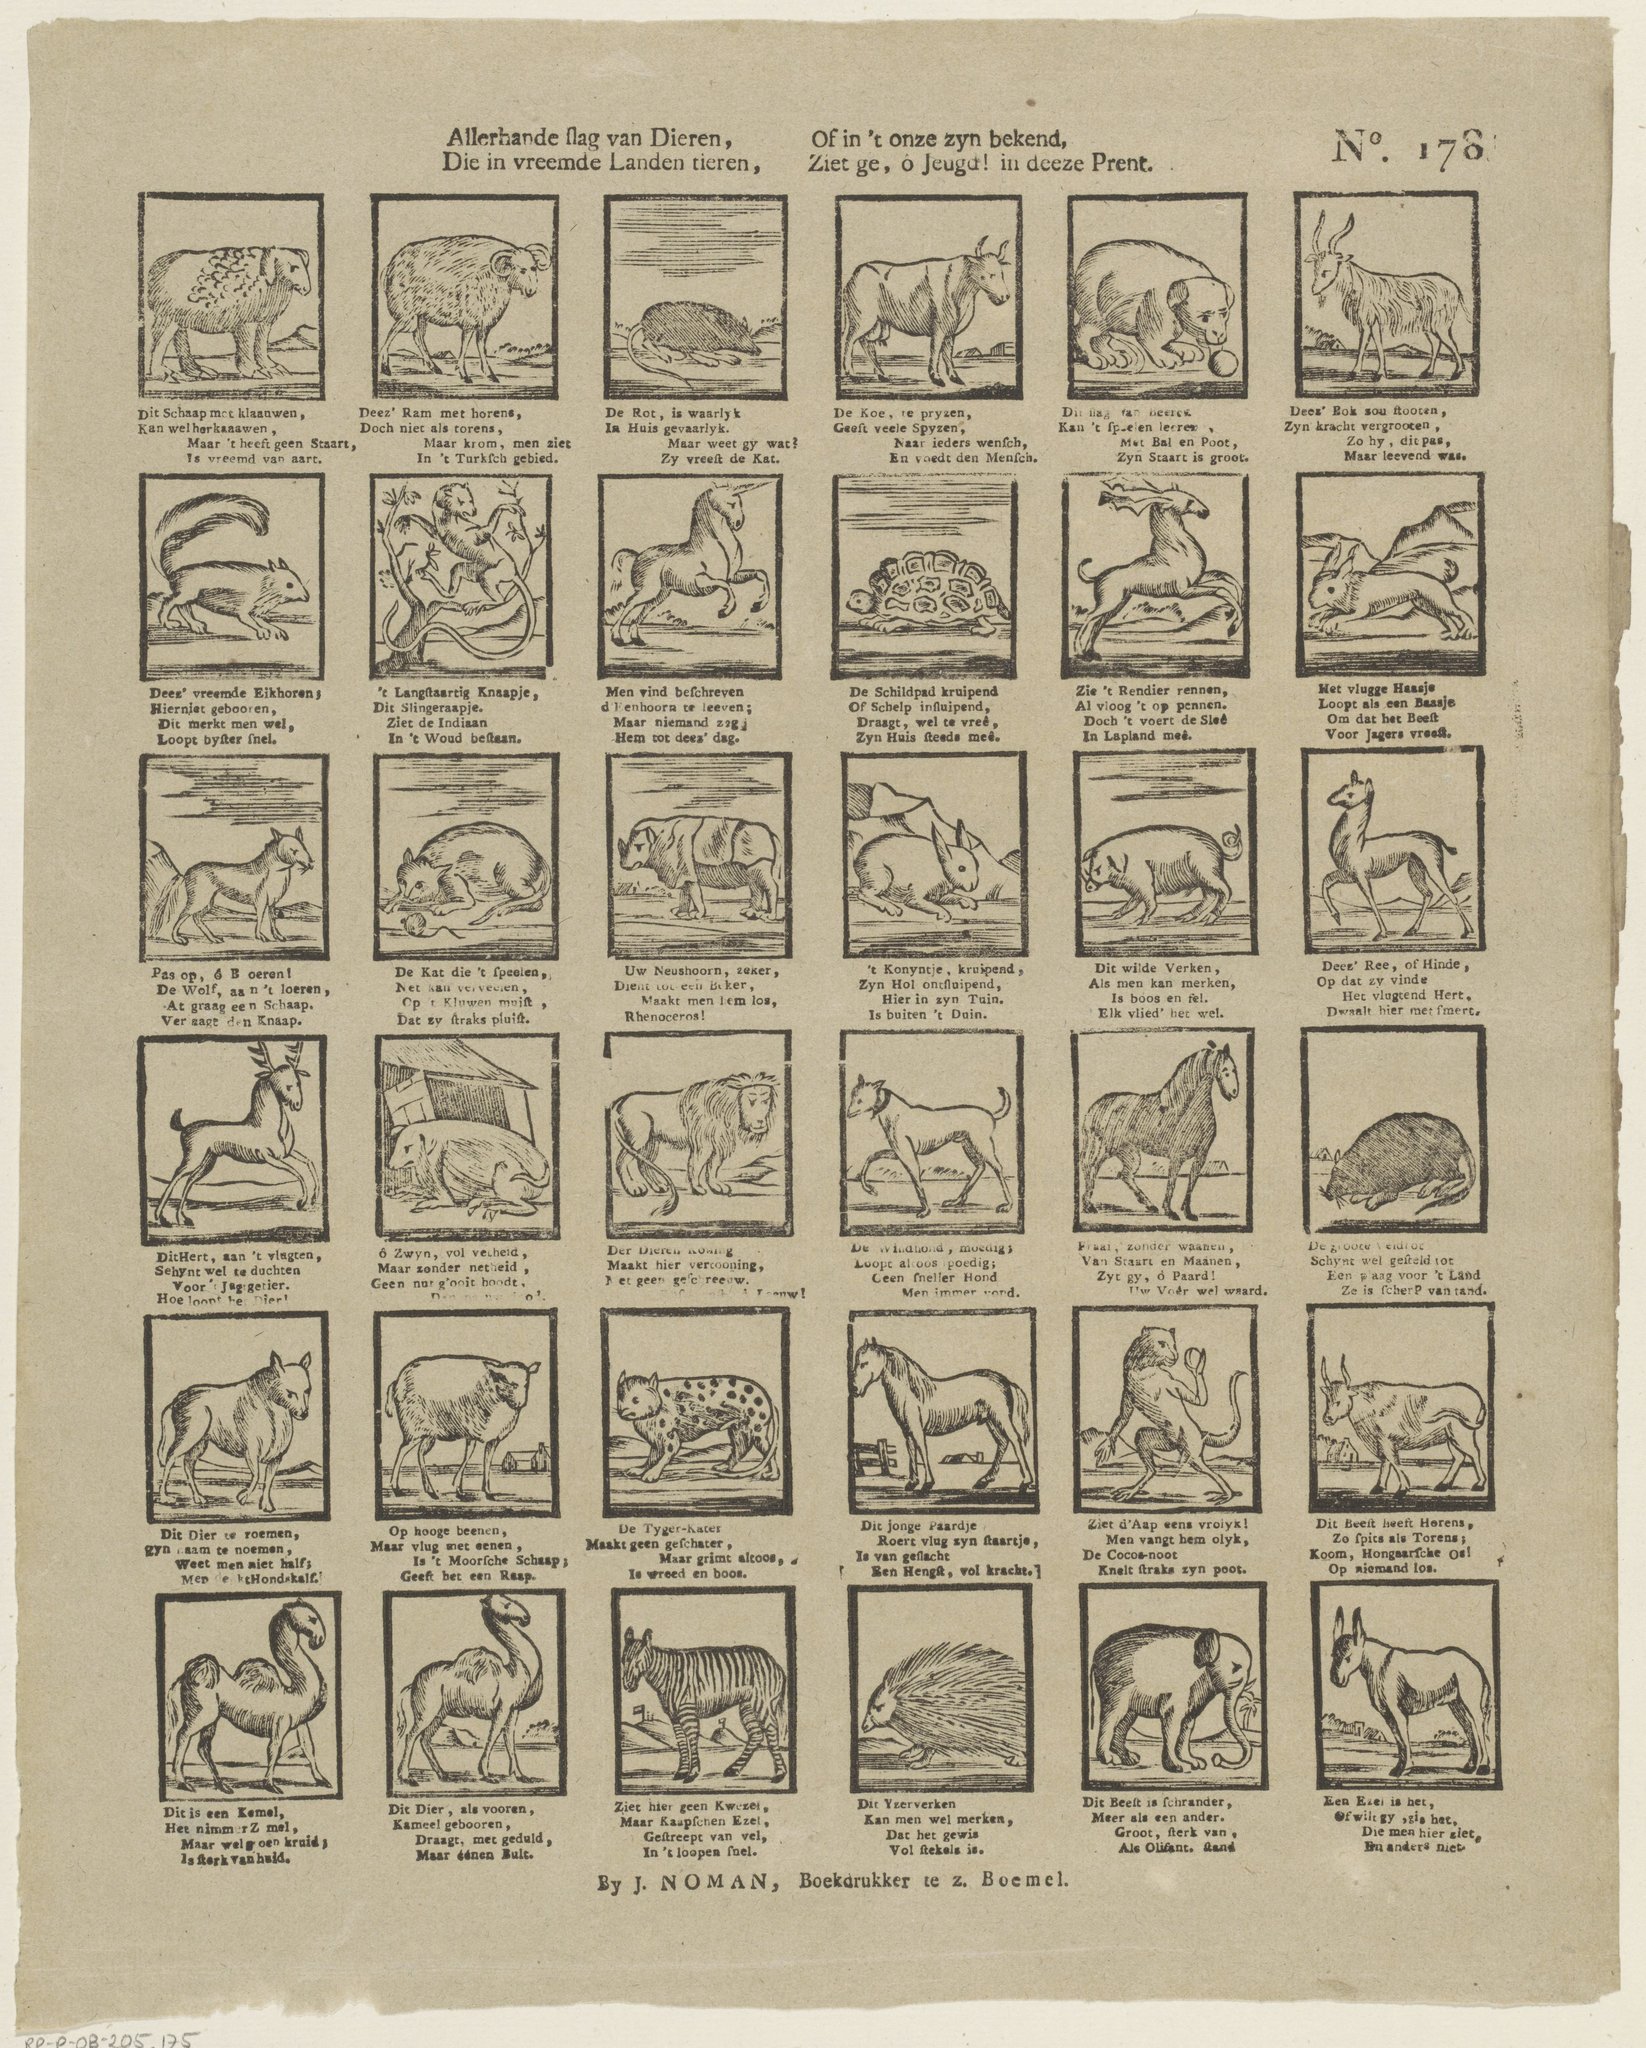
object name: popular print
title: Allerhande slag van dieren, / Die in vreemde landen tieren, / Of in 't onze zyn bekend, / Ziet ge, ô jeugd! in deeze prent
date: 1806-1830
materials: paper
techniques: letterpress printing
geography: zaltbommel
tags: cow, unicorn, animals, rodents: rat, hoofed animals: rhinoceros, sheep, beasts of prey, predatory animals: lion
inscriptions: collector's mark: Lugt 2760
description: Blad met 36 voorstellingen van dieren, zoals een schaap, een ram, een rat, een eenhoorn en een neushoorn. Onder elke afbeelding een vierregelig vers. Genummerd rechtsboven: No. 178.